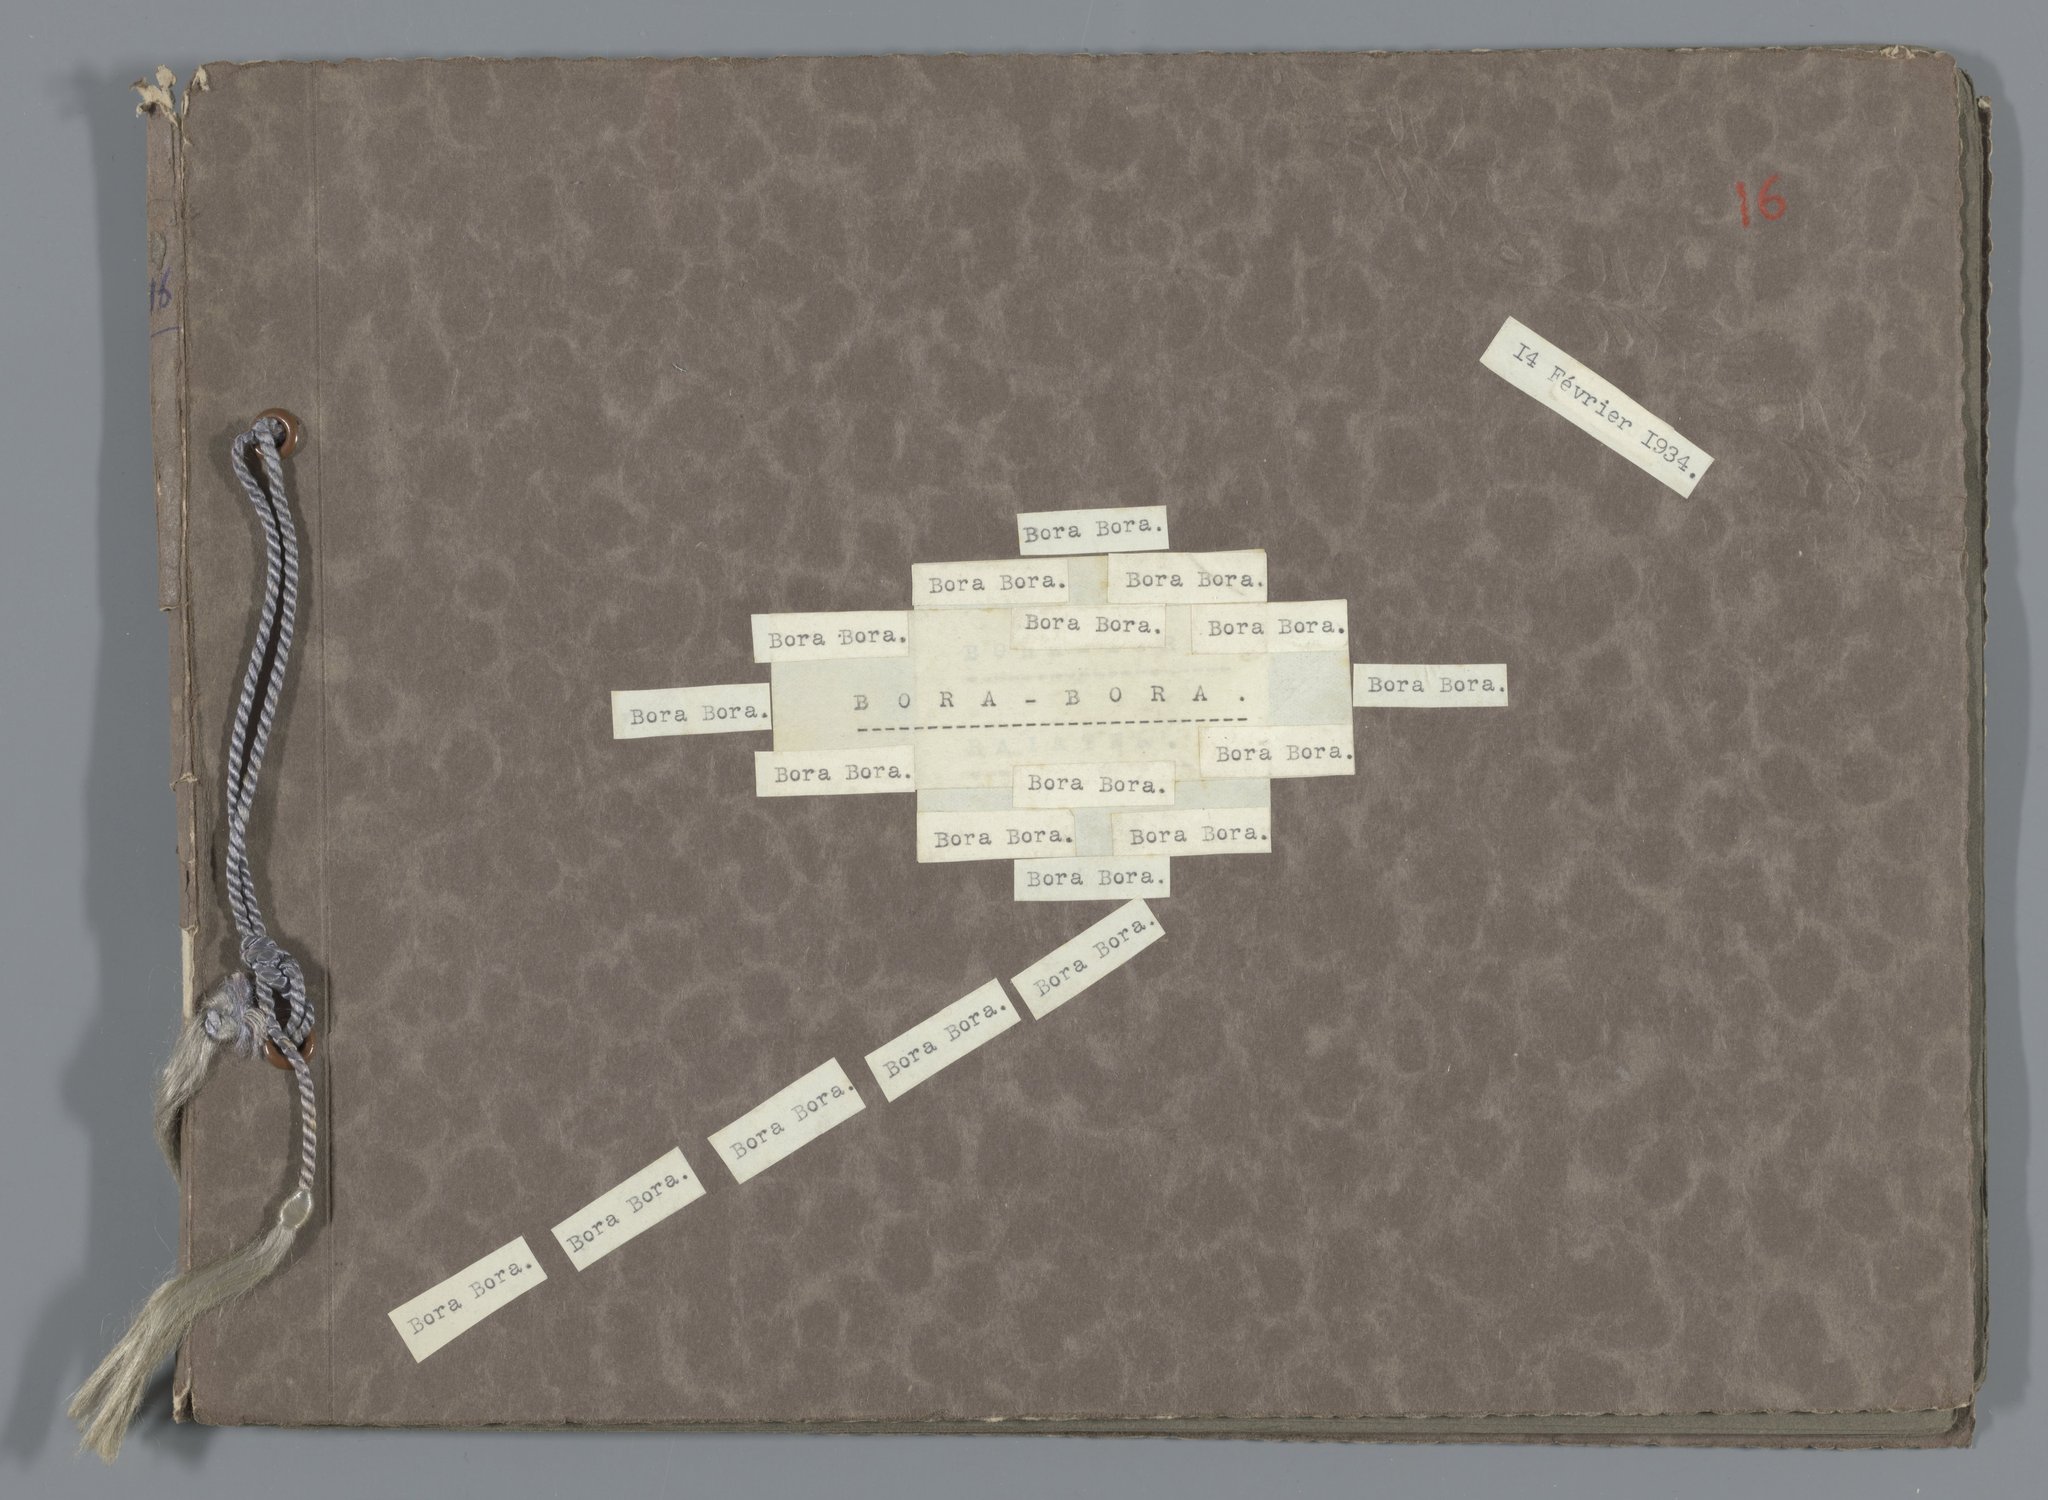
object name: photograph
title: Bora Bora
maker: Anonymous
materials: paper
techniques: gelatin silver print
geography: oceania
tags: oceanië